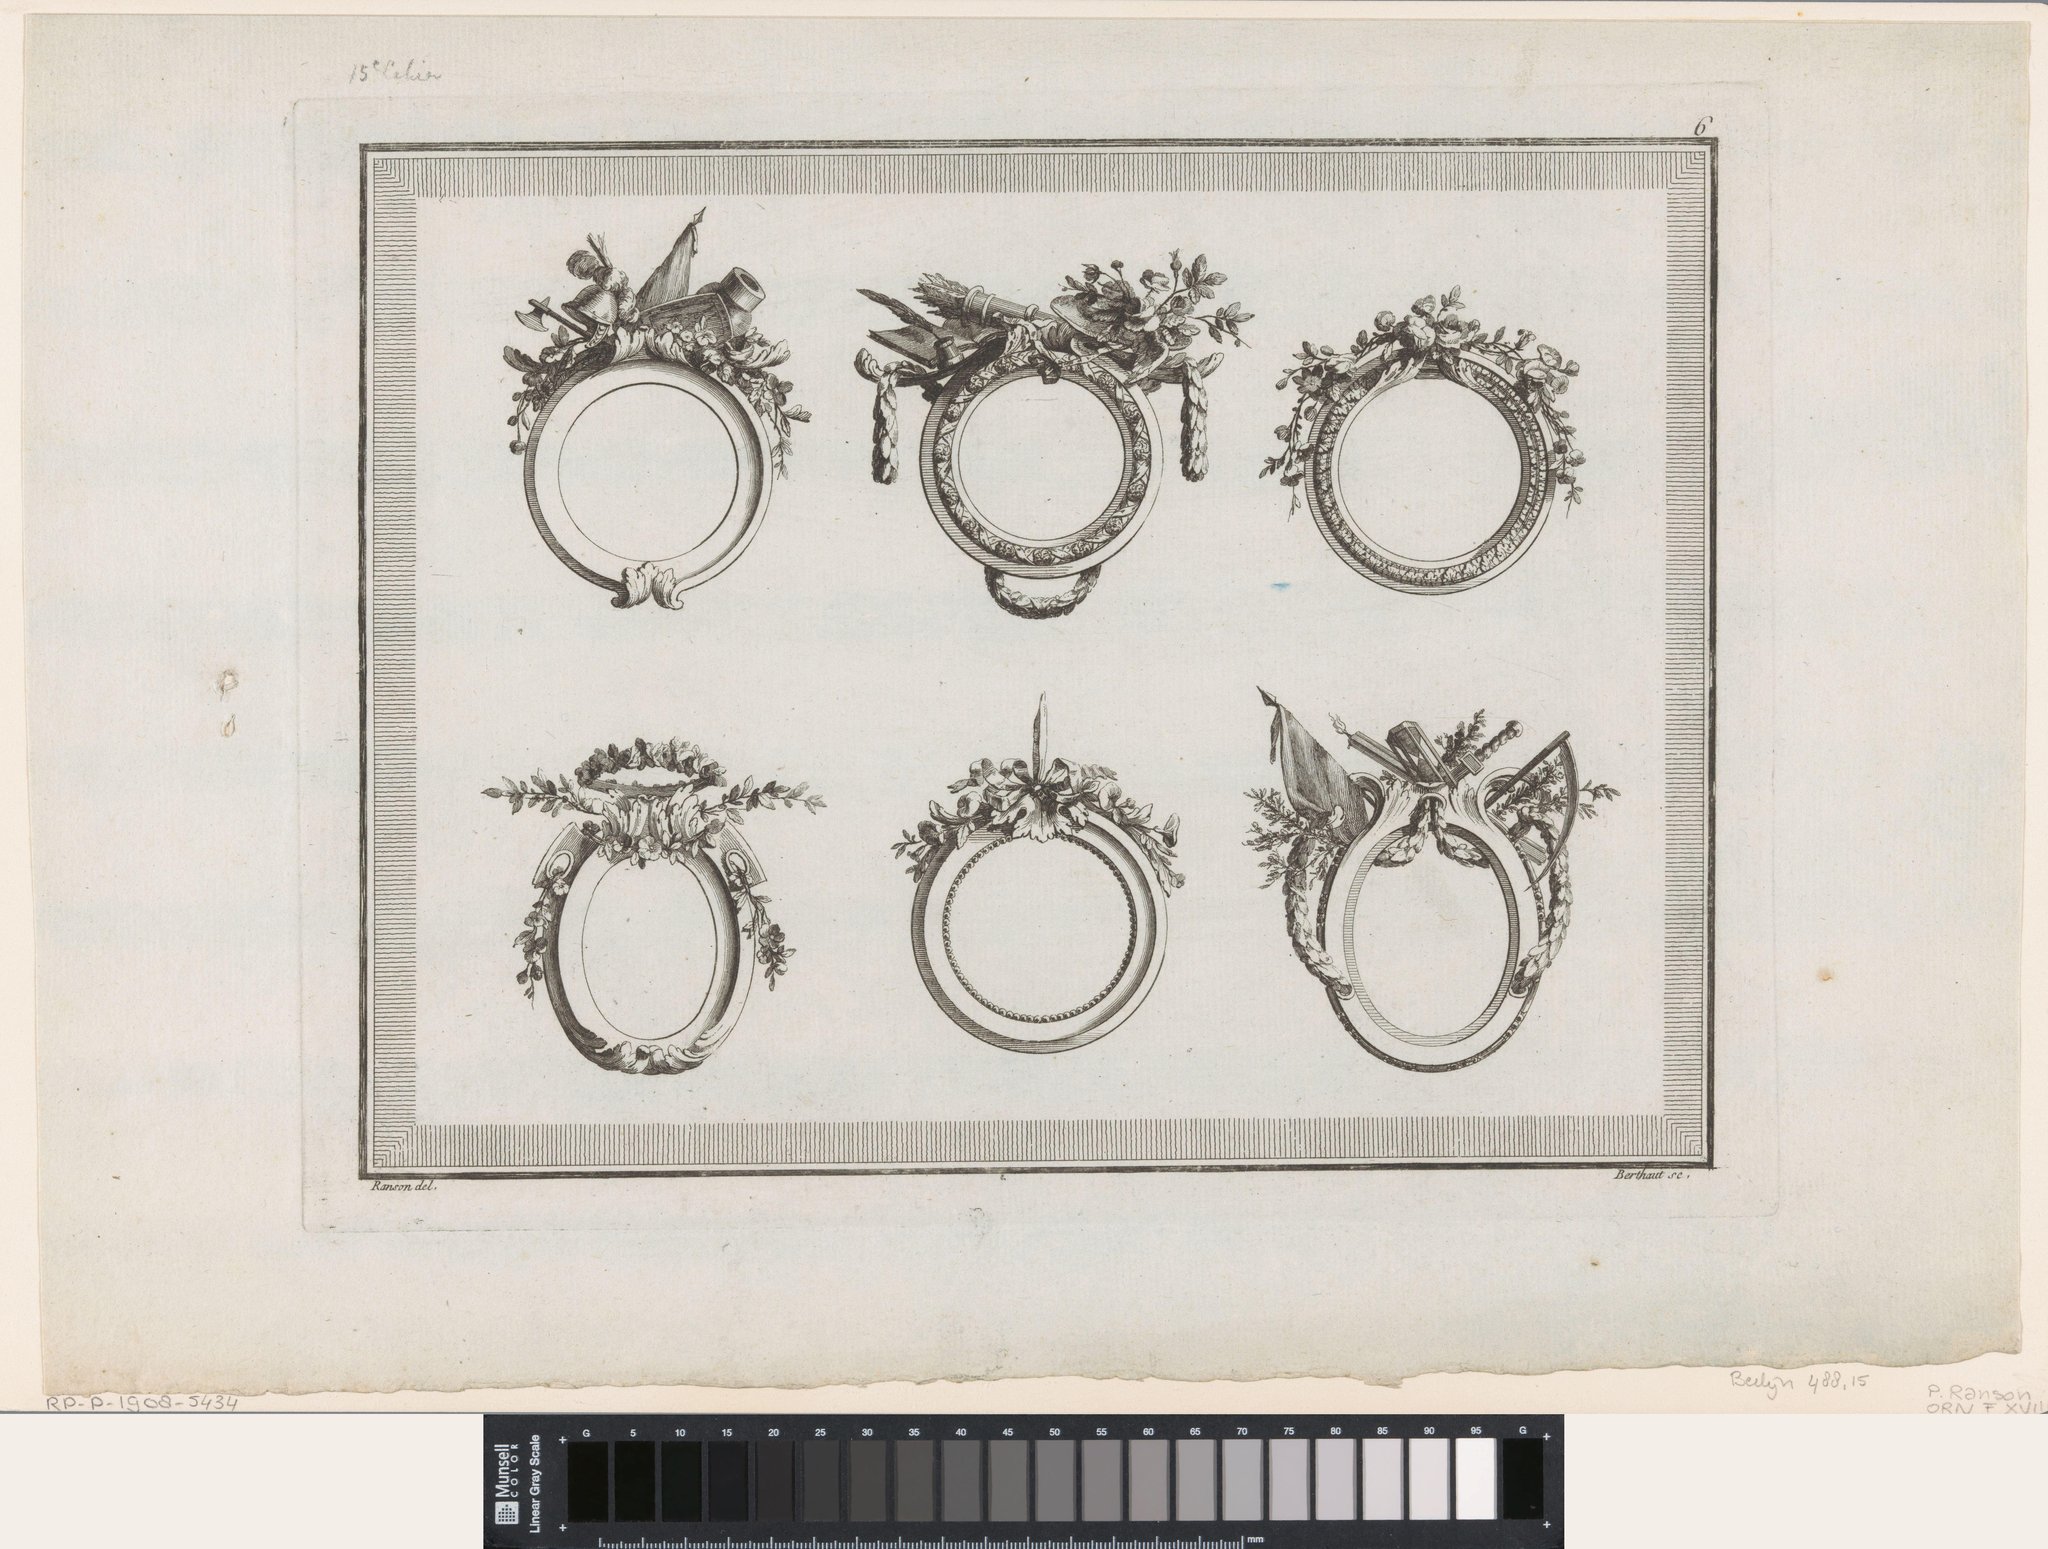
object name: print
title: 15e Cahier de Trophées de l'Oeuvre de Ranson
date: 1778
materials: paper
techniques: etching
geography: paris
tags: flowers, ornament ~ medallion, weapons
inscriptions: collector's mark: Lugt 2228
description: Zes medaillons. Links- en midden boven met wapens. Rechts boven met bloemen. Links onder met een krans. Midden onder met strik. Rechts onder met vlag, zeis, wapens en zandloper.